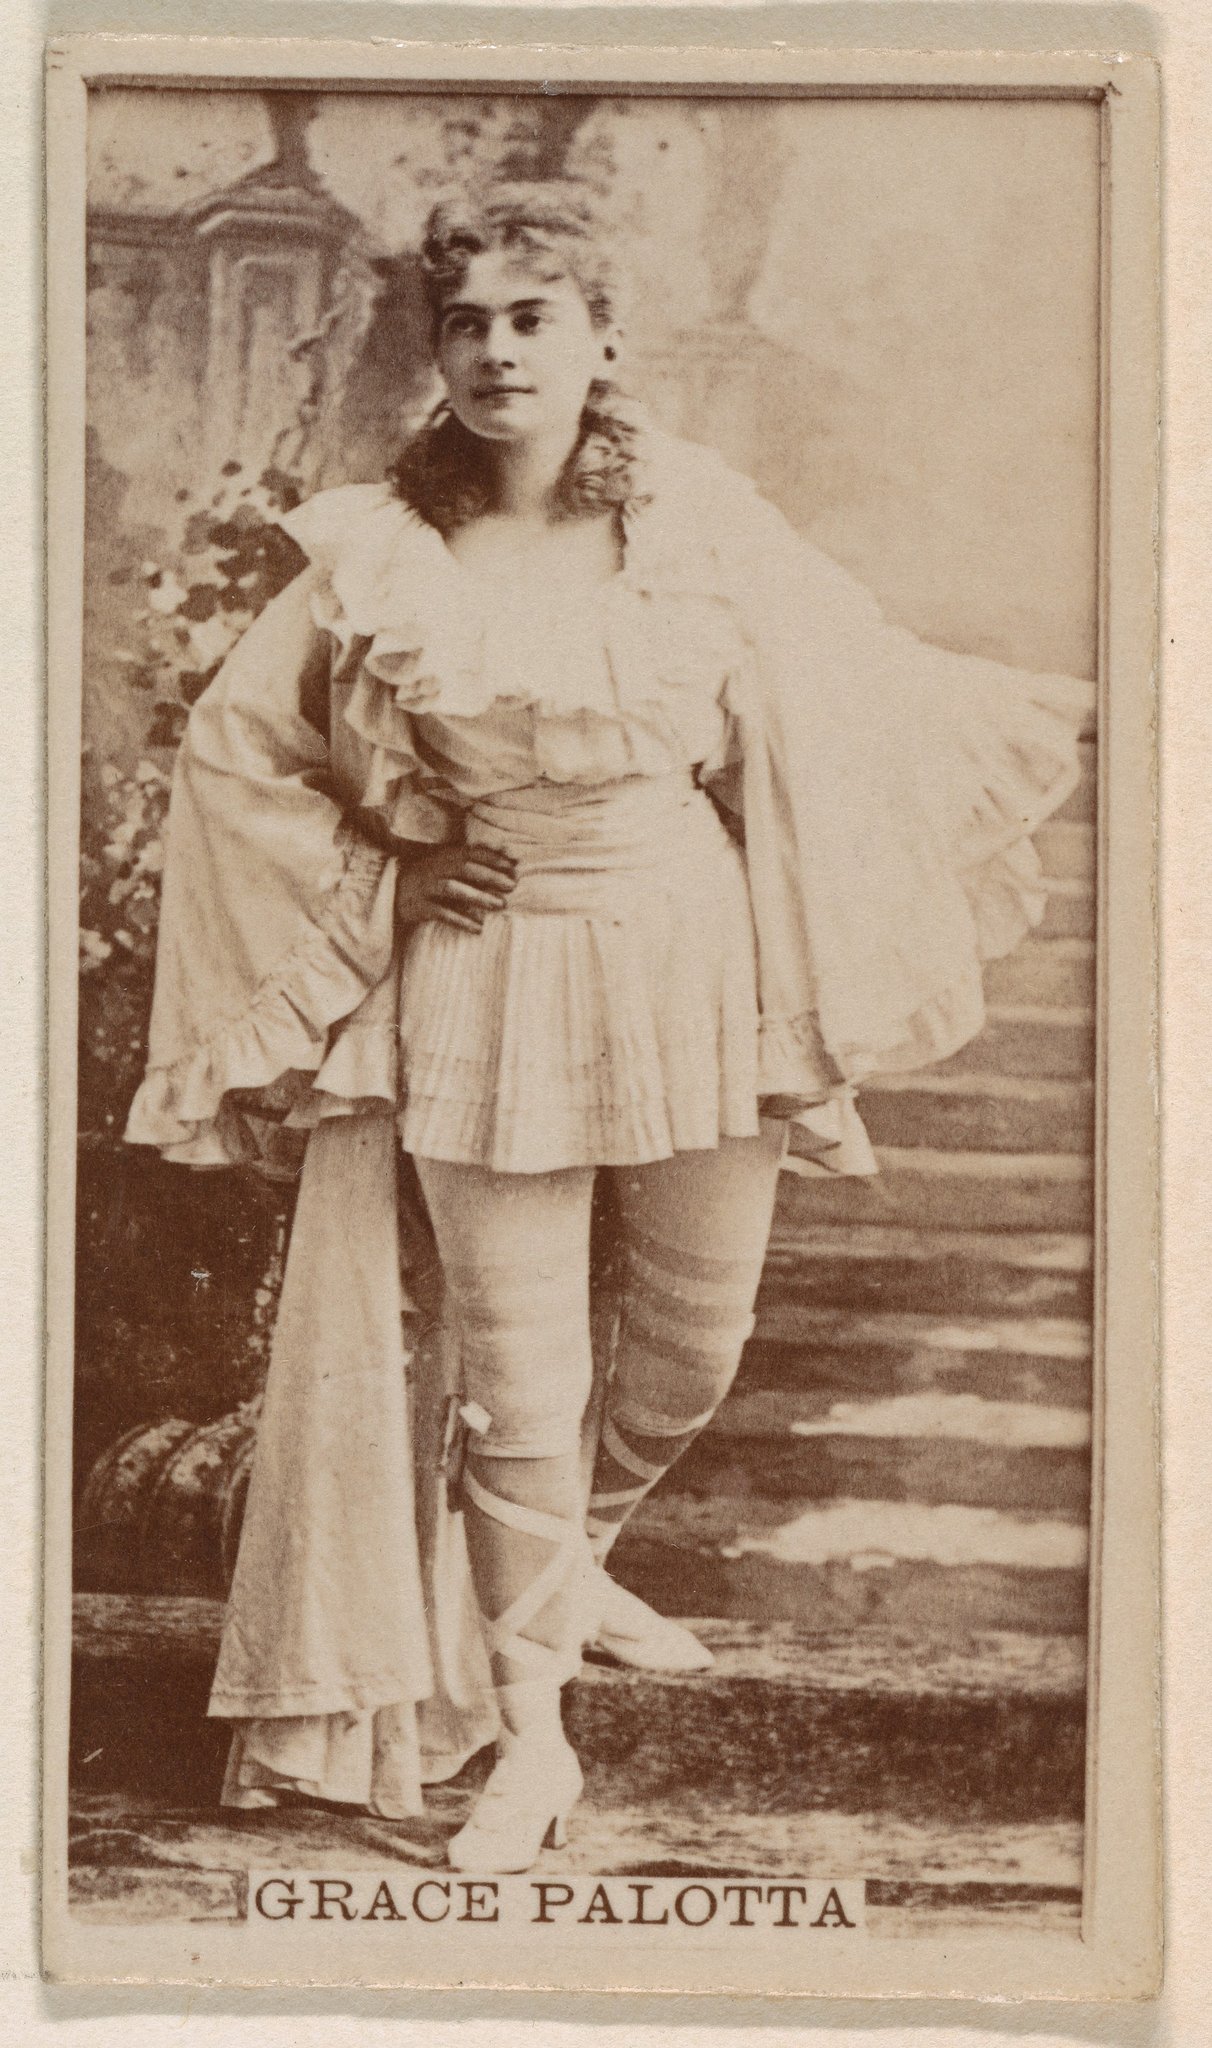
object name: photograph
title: Grace Palotta, from the Actresses series (N245) issued by Kinney Brothers to promote Sweet Caporal Cigarettes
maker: kinney brothers tobacco company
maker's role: publisher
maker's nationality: american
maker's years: 1869-2011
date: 1890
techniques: albumen silver print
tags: portraits,women,actresses